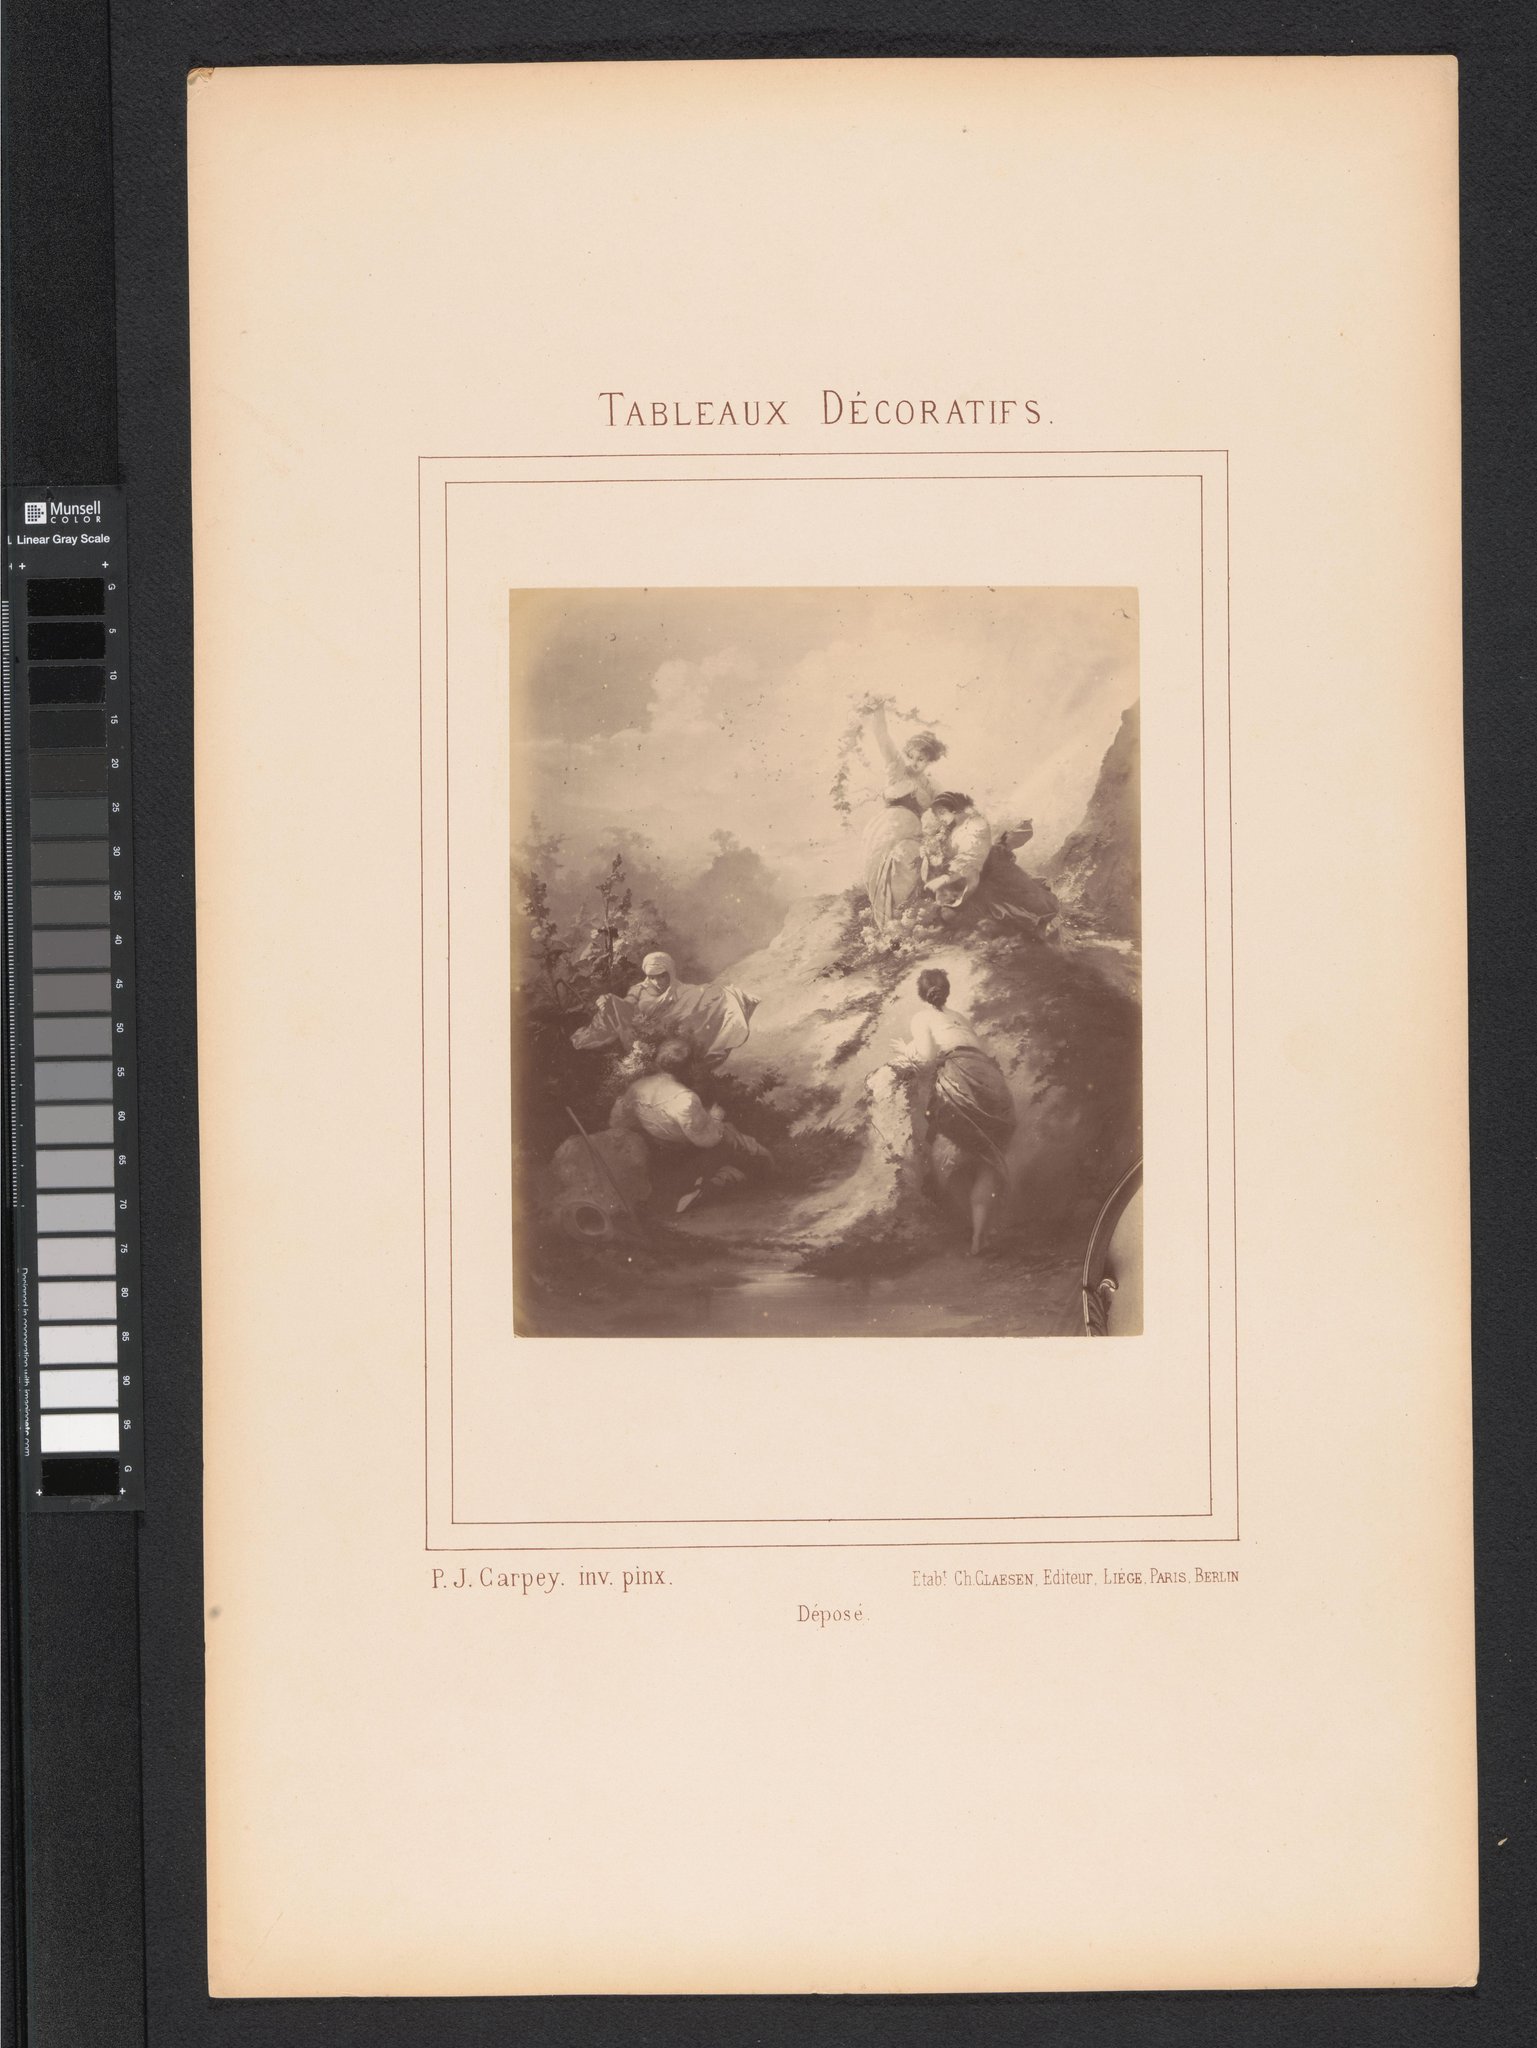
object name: photograph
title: Tableaux Décoratifs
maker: paul-joseph carpay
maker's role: painter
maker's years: 1822-1892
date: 1874-1881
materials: photographic support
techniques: albumen print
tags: low hill country, standing figure, adult woman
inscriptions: inscription: ‘Etabt. Ch.Claesen , Editeur , Liége , Paris , Berlin’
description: Deze foto maakt deel uit van een omslag met 24 foto's op 22 bladen.